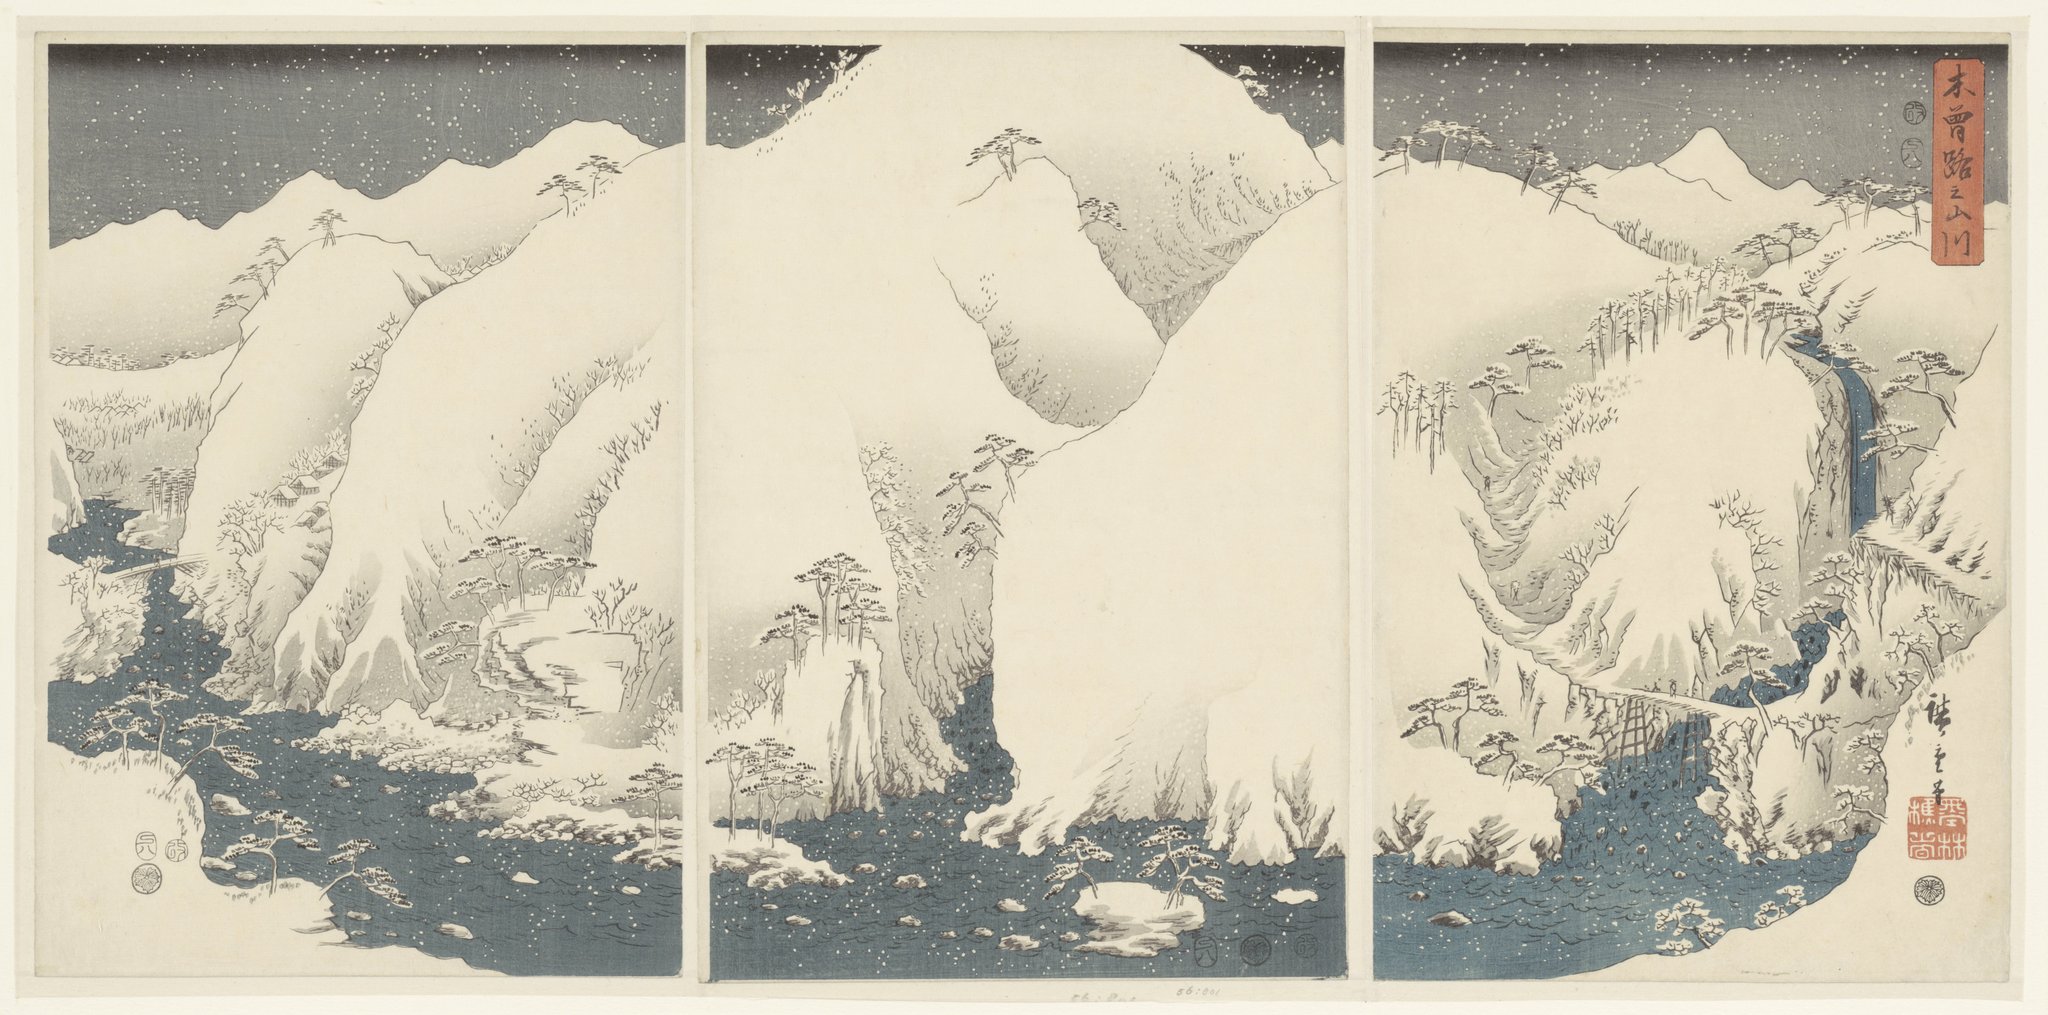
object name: print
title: Setsugekka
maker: utagawa hiroshige (i)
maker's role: draughtsman, print maker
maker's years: 1797-1858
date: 1808-1857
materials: paper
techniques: woodcut, nishiki e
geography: tokyo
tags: mountain-range, snow peaks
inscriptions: date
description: Gezicht op een besneeuwd berglandschap. Op de bruggen over de rivier en op de bergpaden zijn reizigers over de Kiso route, destijds één van de belangrijkste wegen door Japan, afgebeeld.